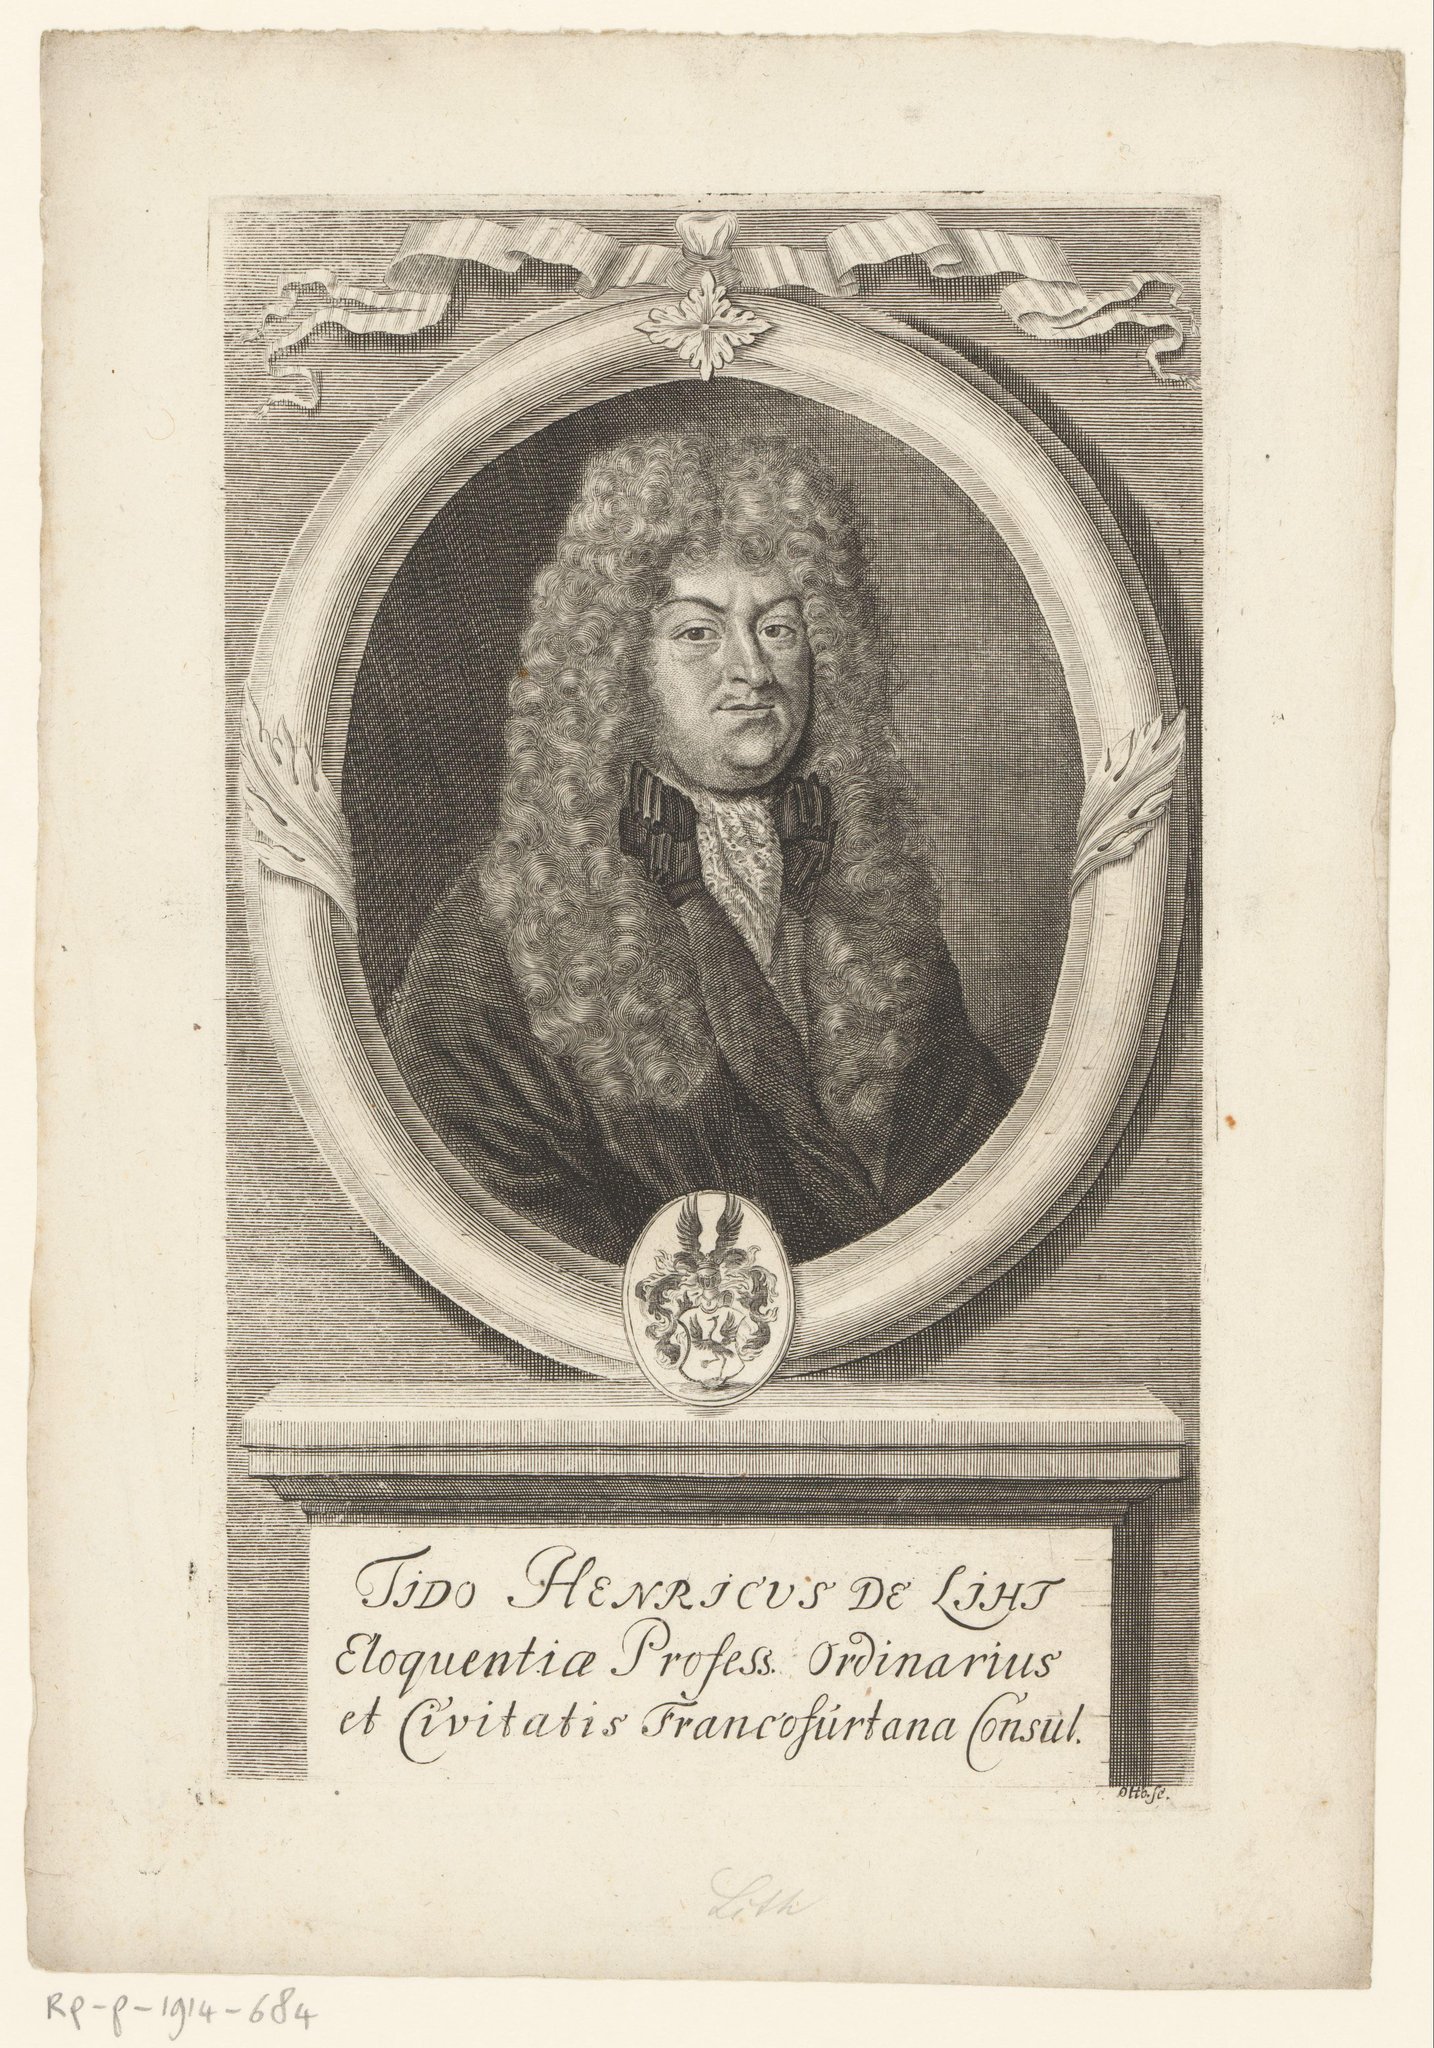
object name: print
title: Portret van Tido Henrich von der Lith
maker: heinrich jakob otto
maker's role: print maker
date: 1649-1693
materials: paper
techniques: engraving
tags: historical persons, armorial bearing, heraldry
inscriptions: collector's mark: Lugt 2228